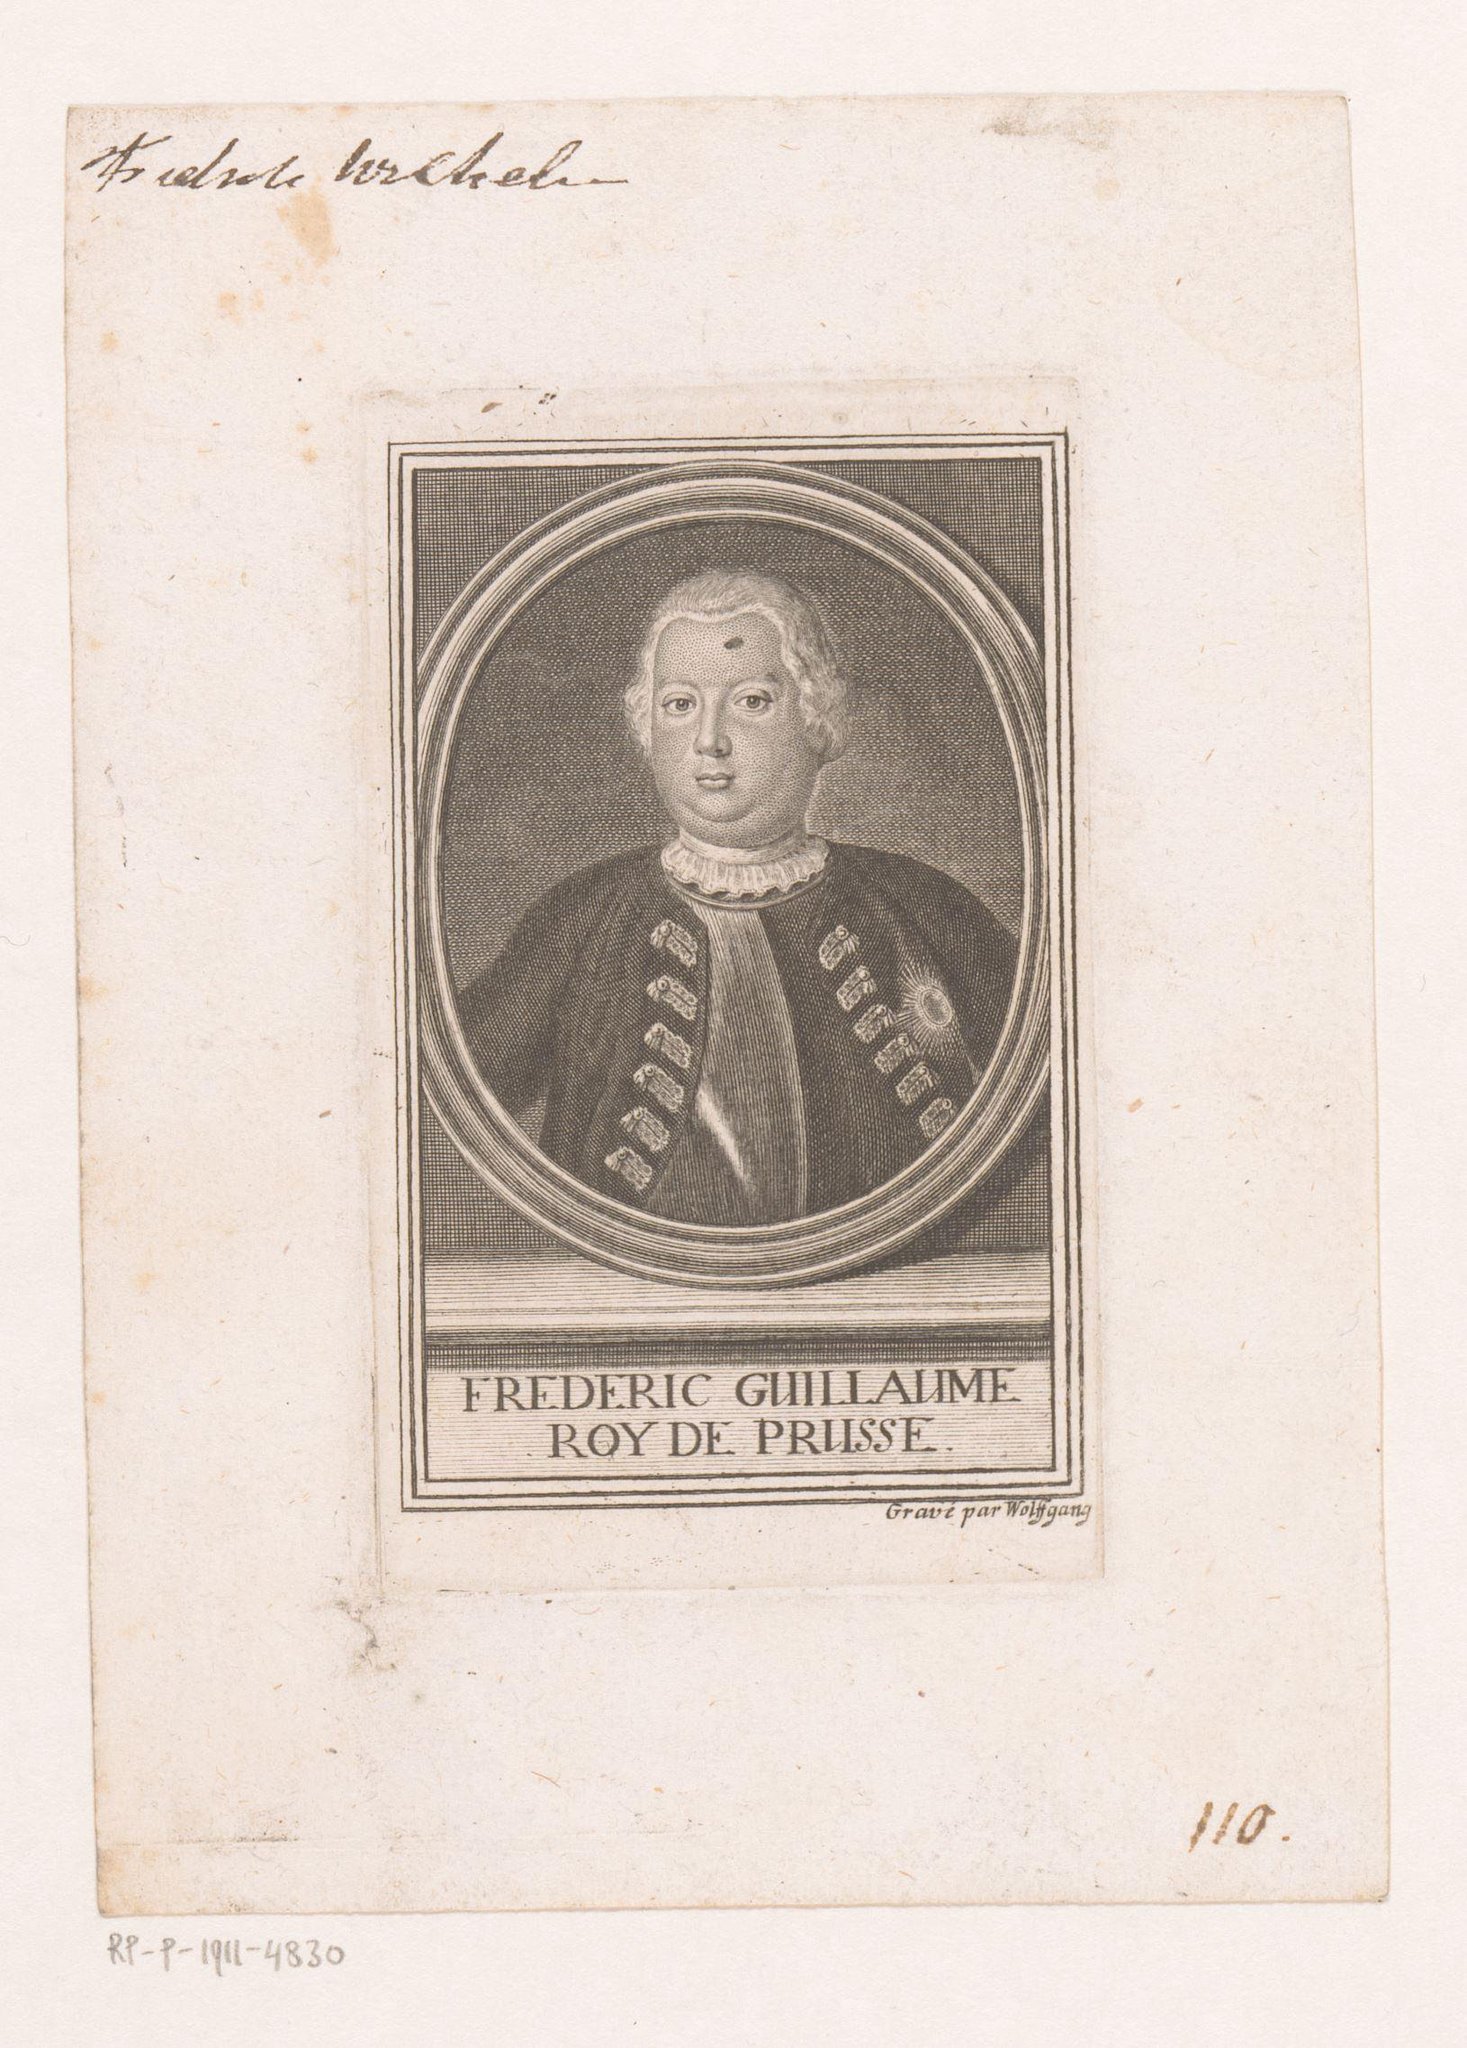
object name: print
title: Portret van Frederik Willem I, koning van Pruisen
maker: gustav andreas wolfgang (1692-1775)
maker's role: print maker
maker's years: 1692-1775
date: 1713-1775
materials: paper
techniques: engraving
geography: germany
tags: berlin, frederik willem i koning van pruisen, historical persons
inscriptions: number: ‘110’, collector's mark: Lugt 2228